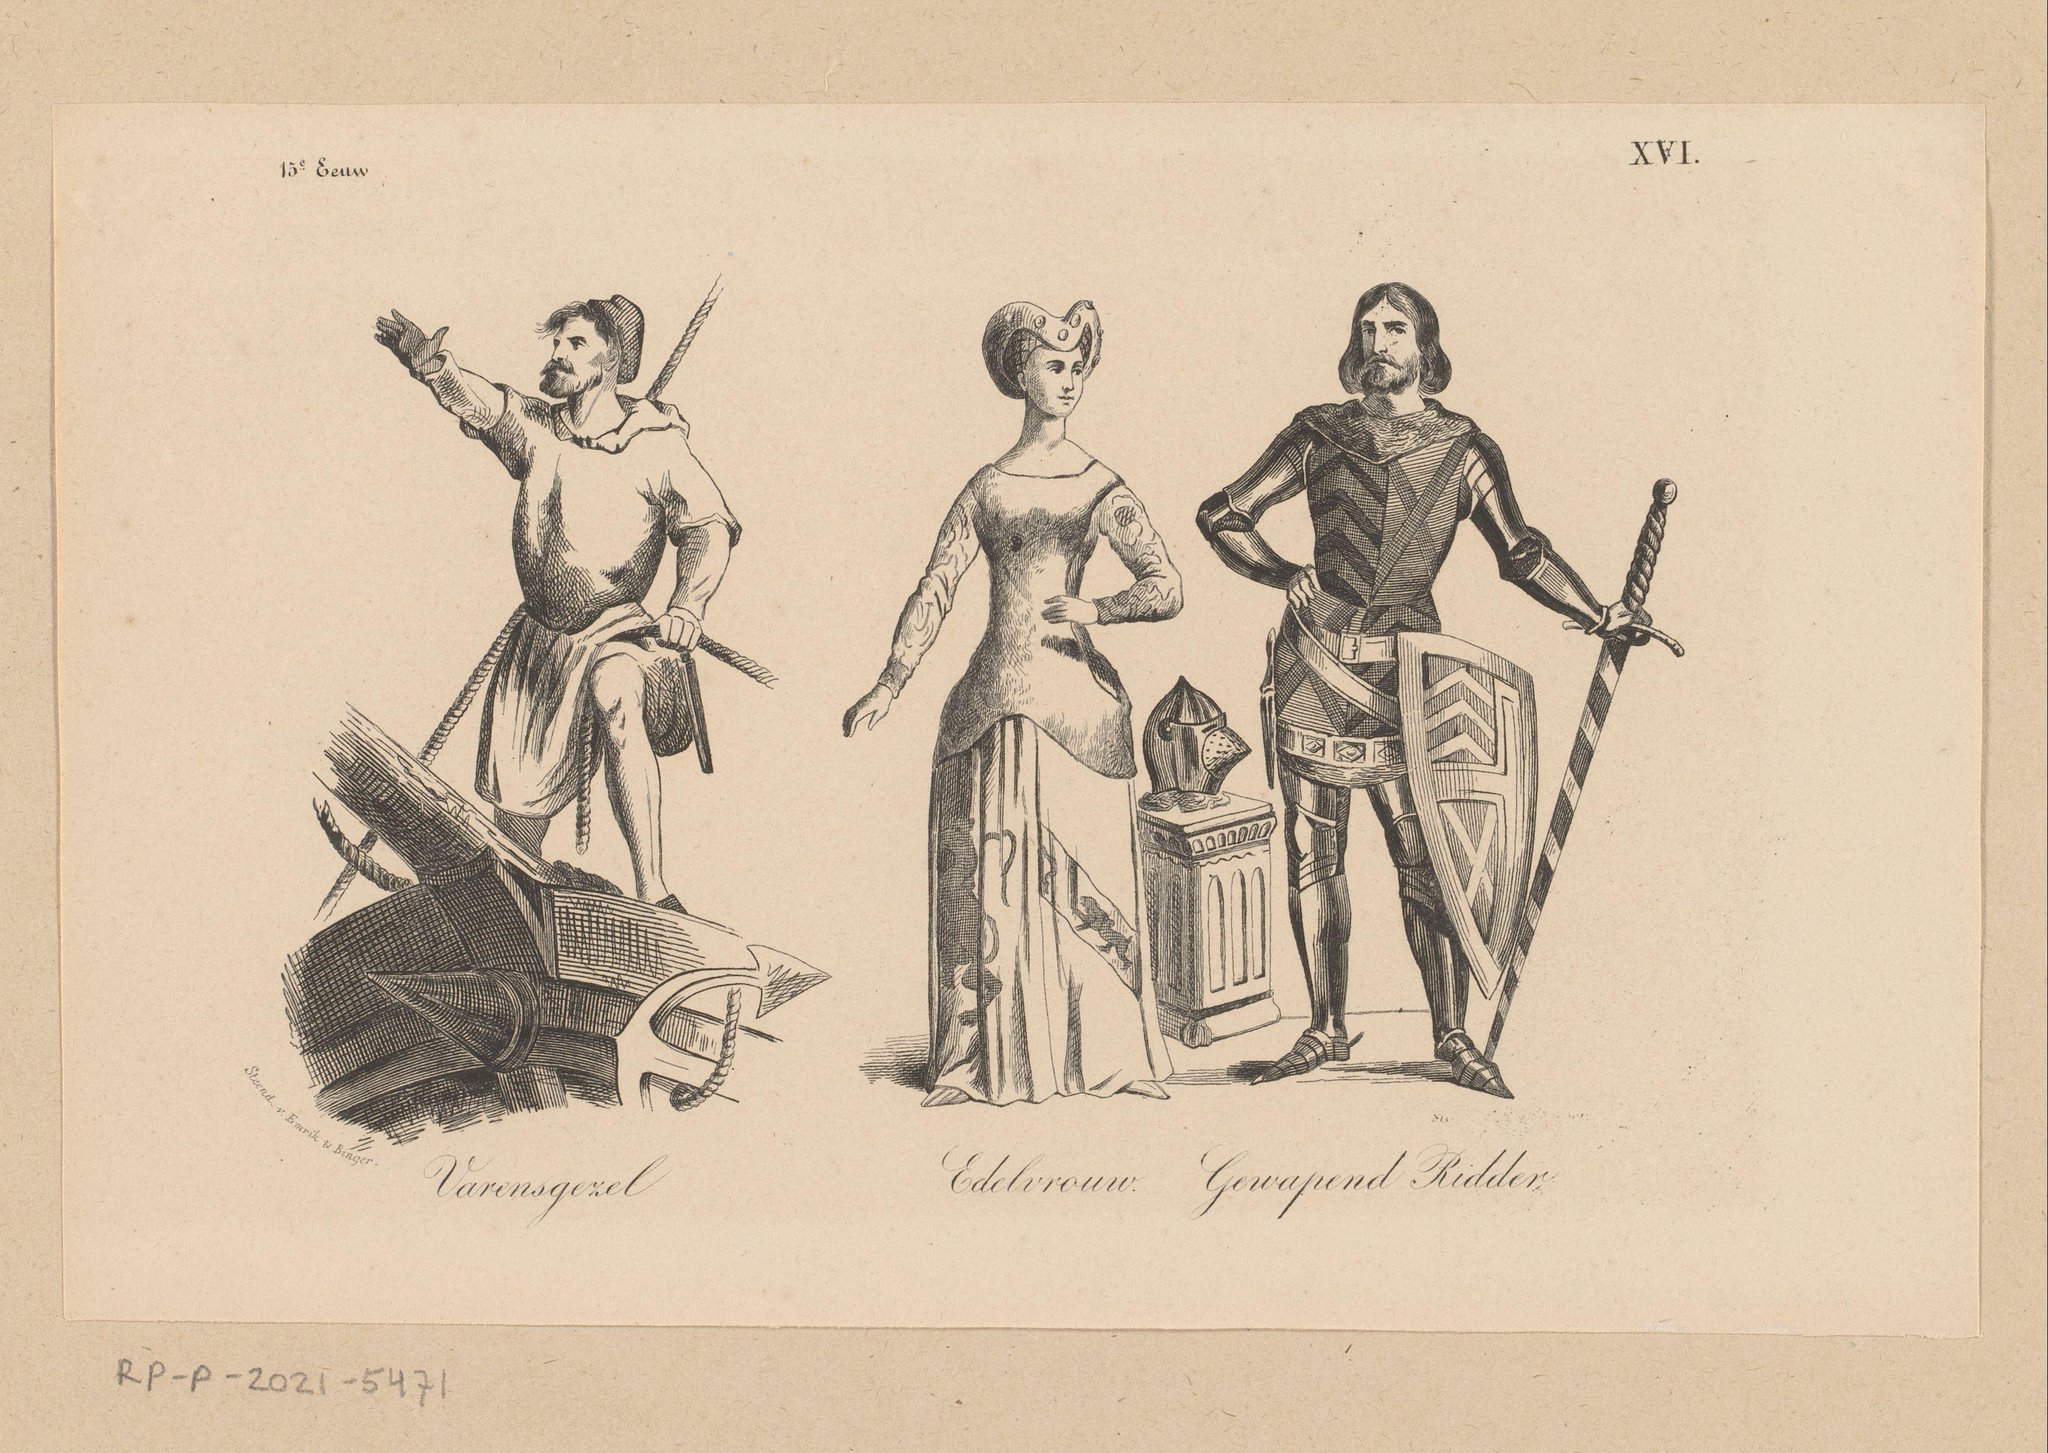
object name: costume print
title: Zeeman, edelvrouw en ridder in kleding uit de vijftiende eeuw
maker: Anonymous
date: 1857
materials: paper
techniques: lithograph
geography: netherlands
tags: seaman, clothes, costume, knight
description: Prent waarschijnlijk uit: Hofdijk, Willem Jacob. Schets van de geschiedenis der Nederlanden. Amsterdam: Gebroeders Binger, 1857.